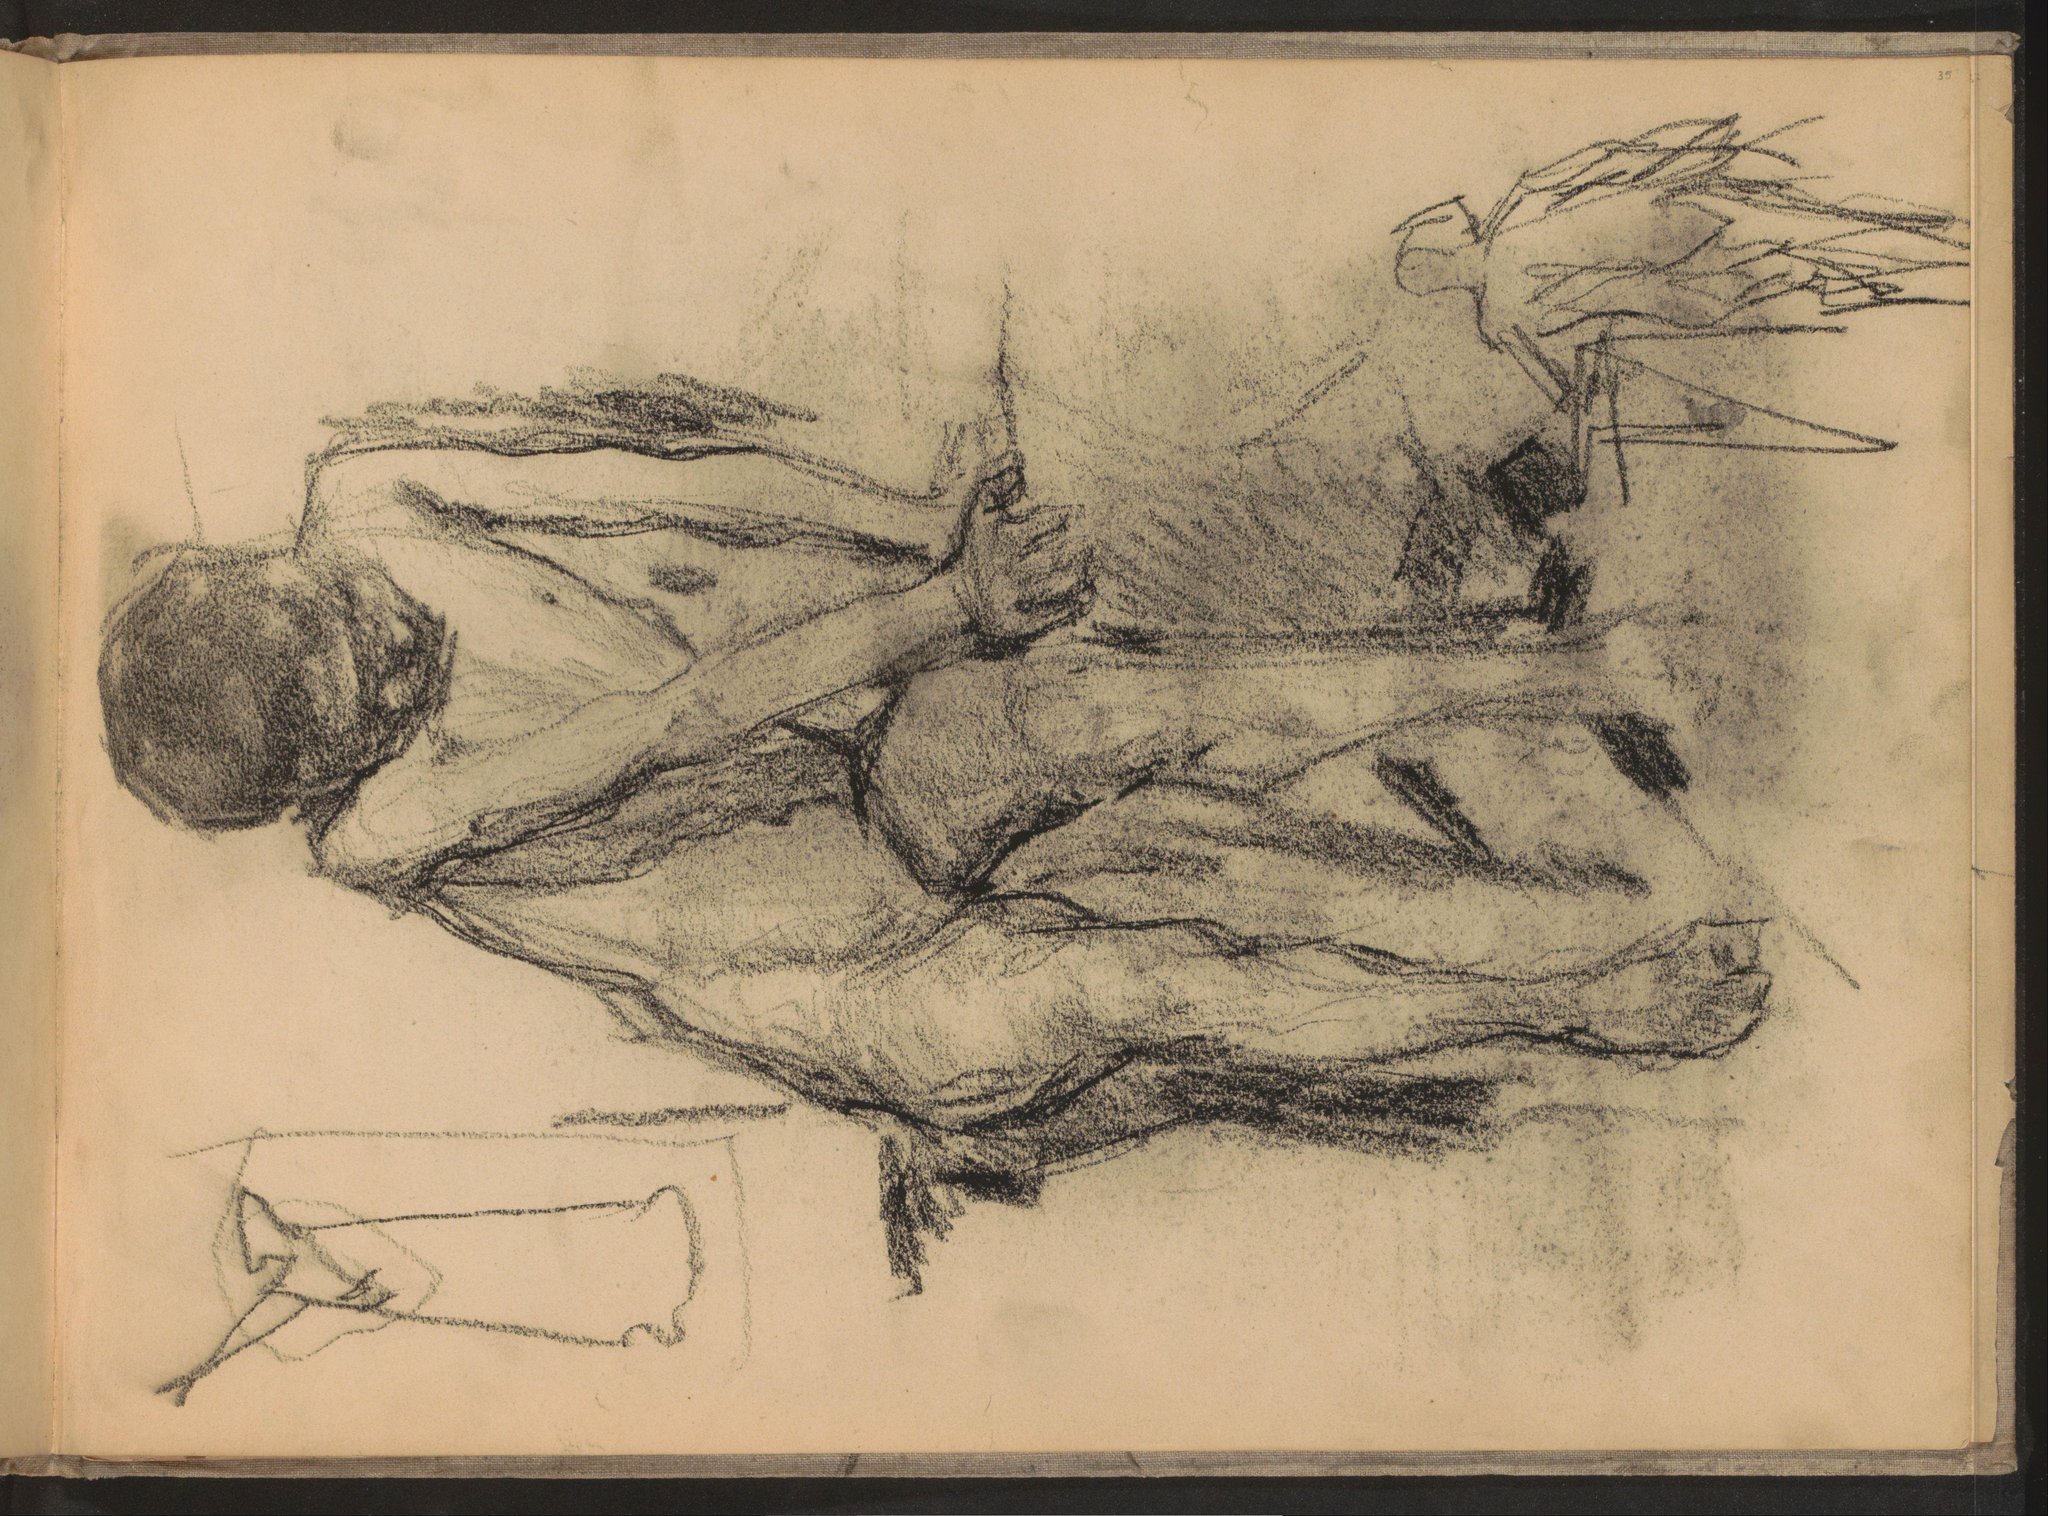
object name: sketchbook leaf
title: Zittende naakte jongen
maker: marius bauer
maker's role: draughtsman, print maker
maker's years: 1867-1932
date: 1887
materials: chalk, paper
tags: sitting figure, boy (child between toddler and youth), the (nude) human figure; 'corpo humano' (ripa) - aa - female human figure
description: Tevens twee figuurstudies. Pagina 35 uit een schetsboek met 19 bladen.